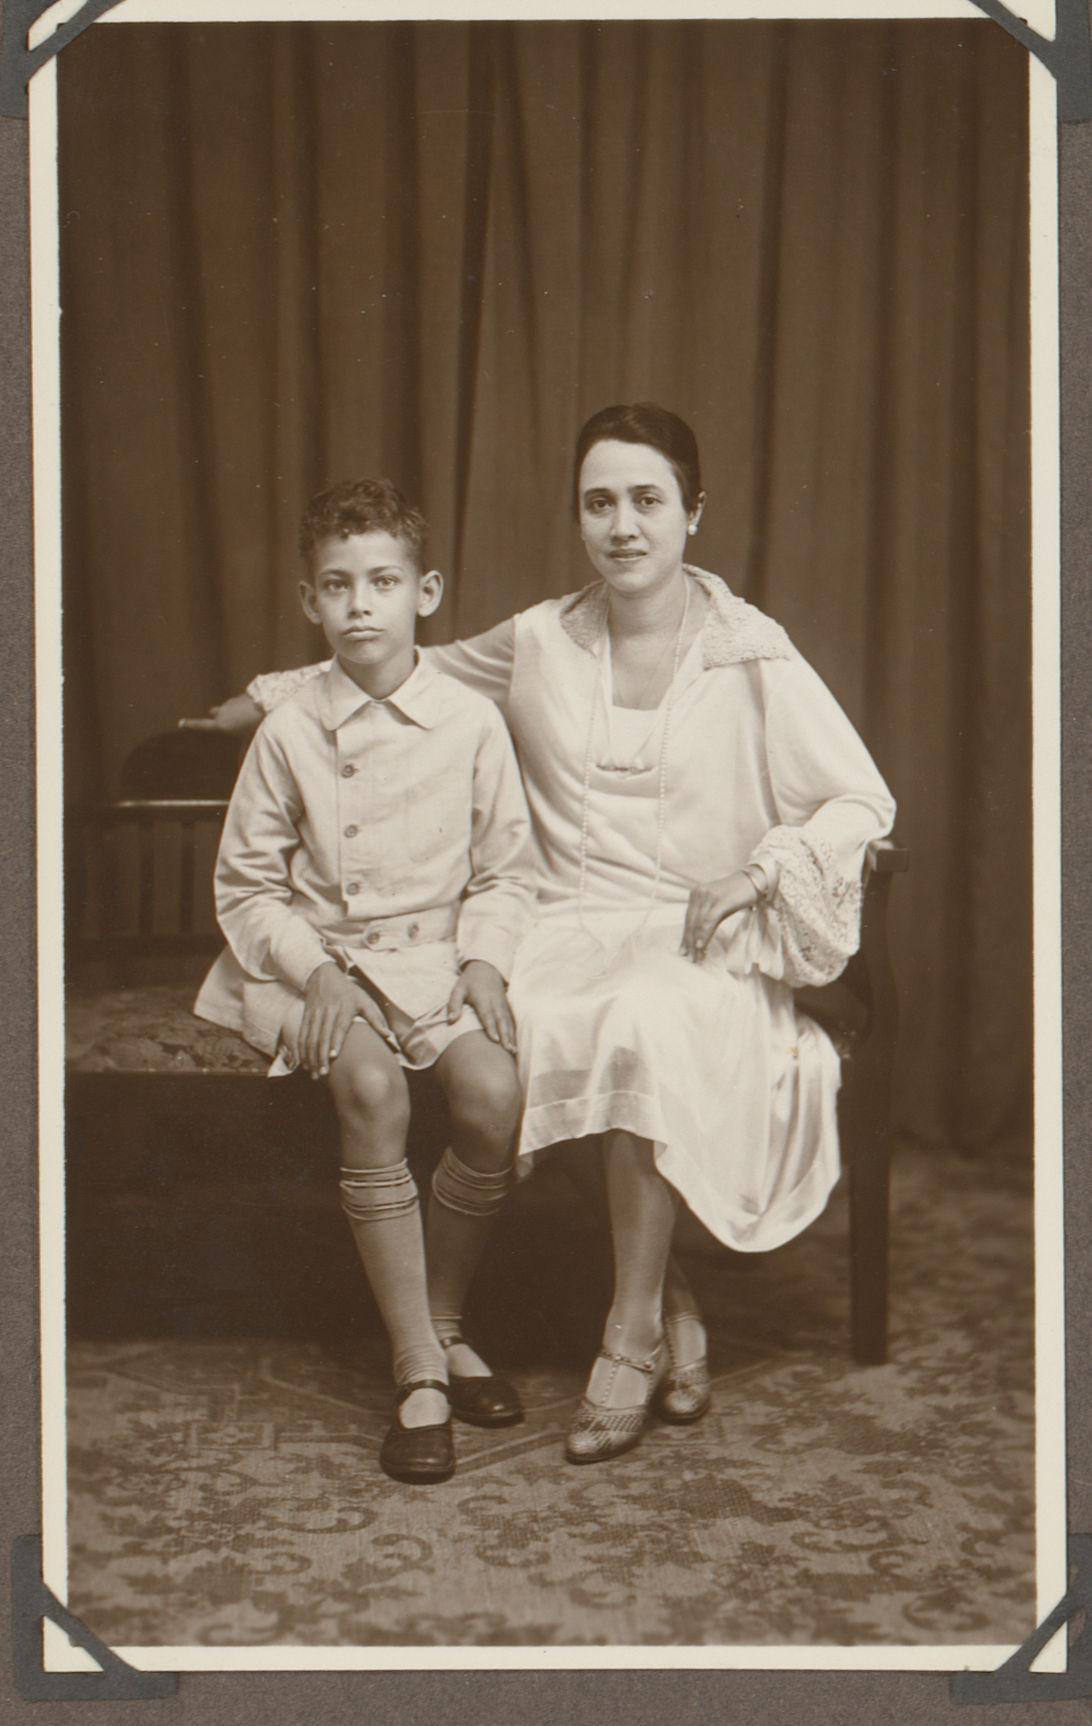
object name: photograph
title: Portret van een vrouw en een jongen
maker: Anonymous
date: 1930-1935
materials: paper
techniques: gelatin silver print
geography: dutch east indies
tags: adult woman, boy (child between toddler and youth), historical persons, dutch east indies, the